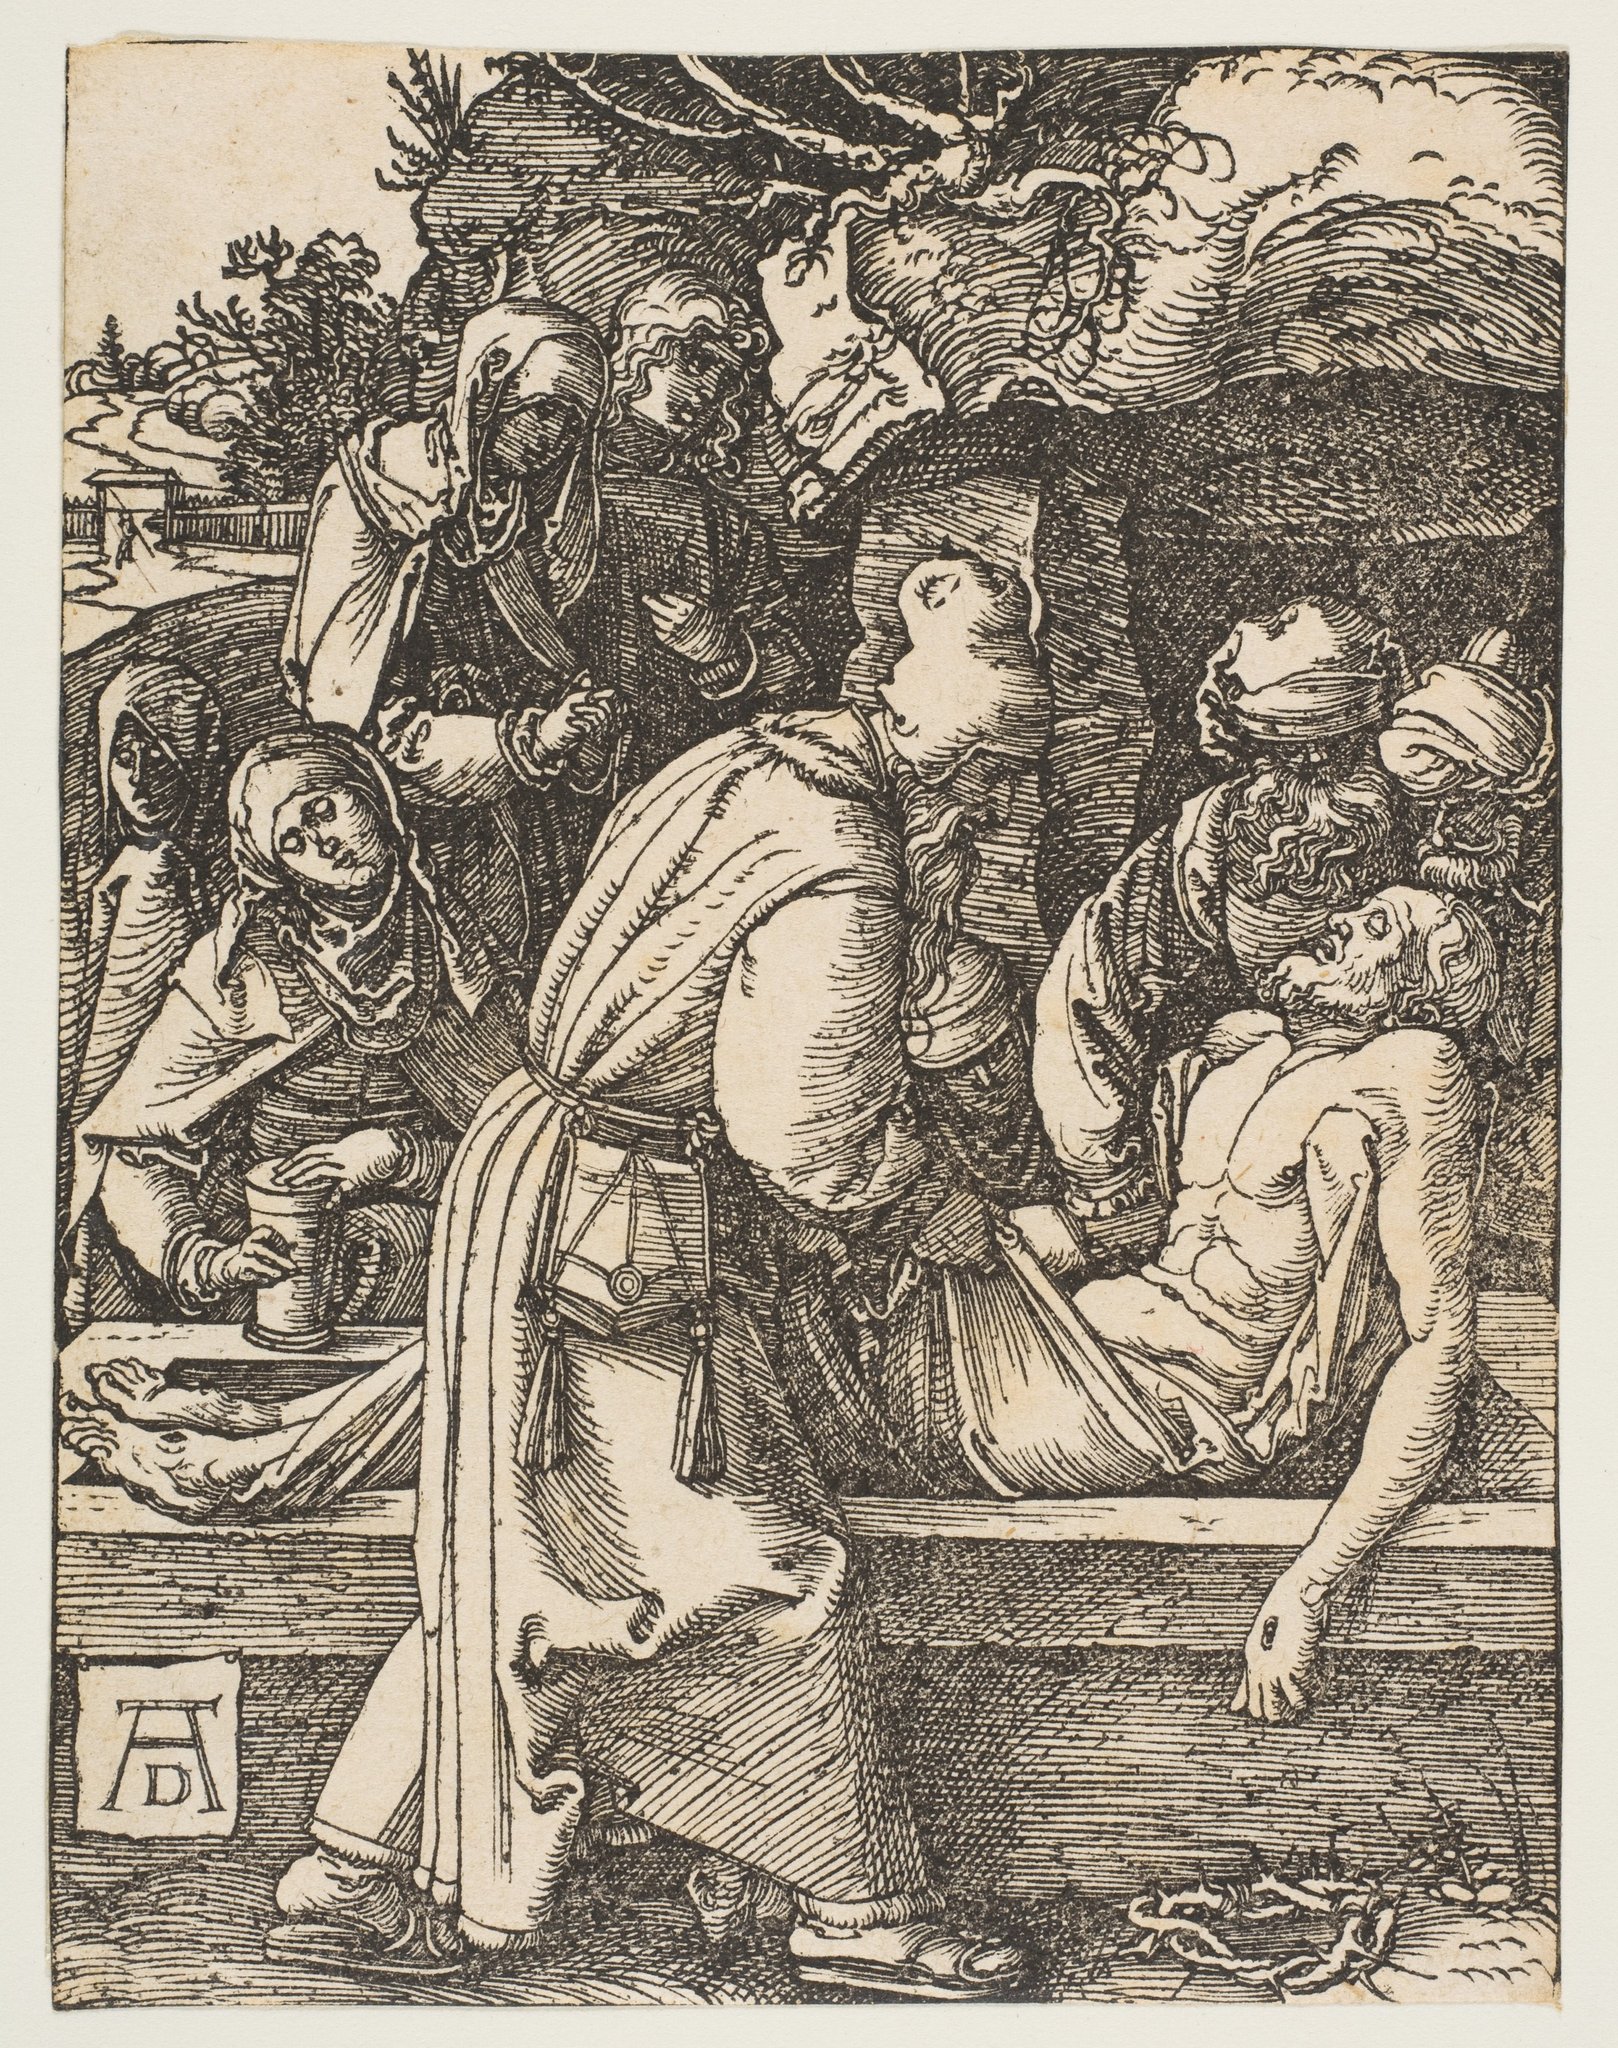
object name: print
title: The Deposition, from "The Small Passion"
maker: albrecht dürer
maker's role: artist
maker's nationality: german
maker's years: 1471-1528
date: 1509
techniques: woodcut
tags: men,women,christ